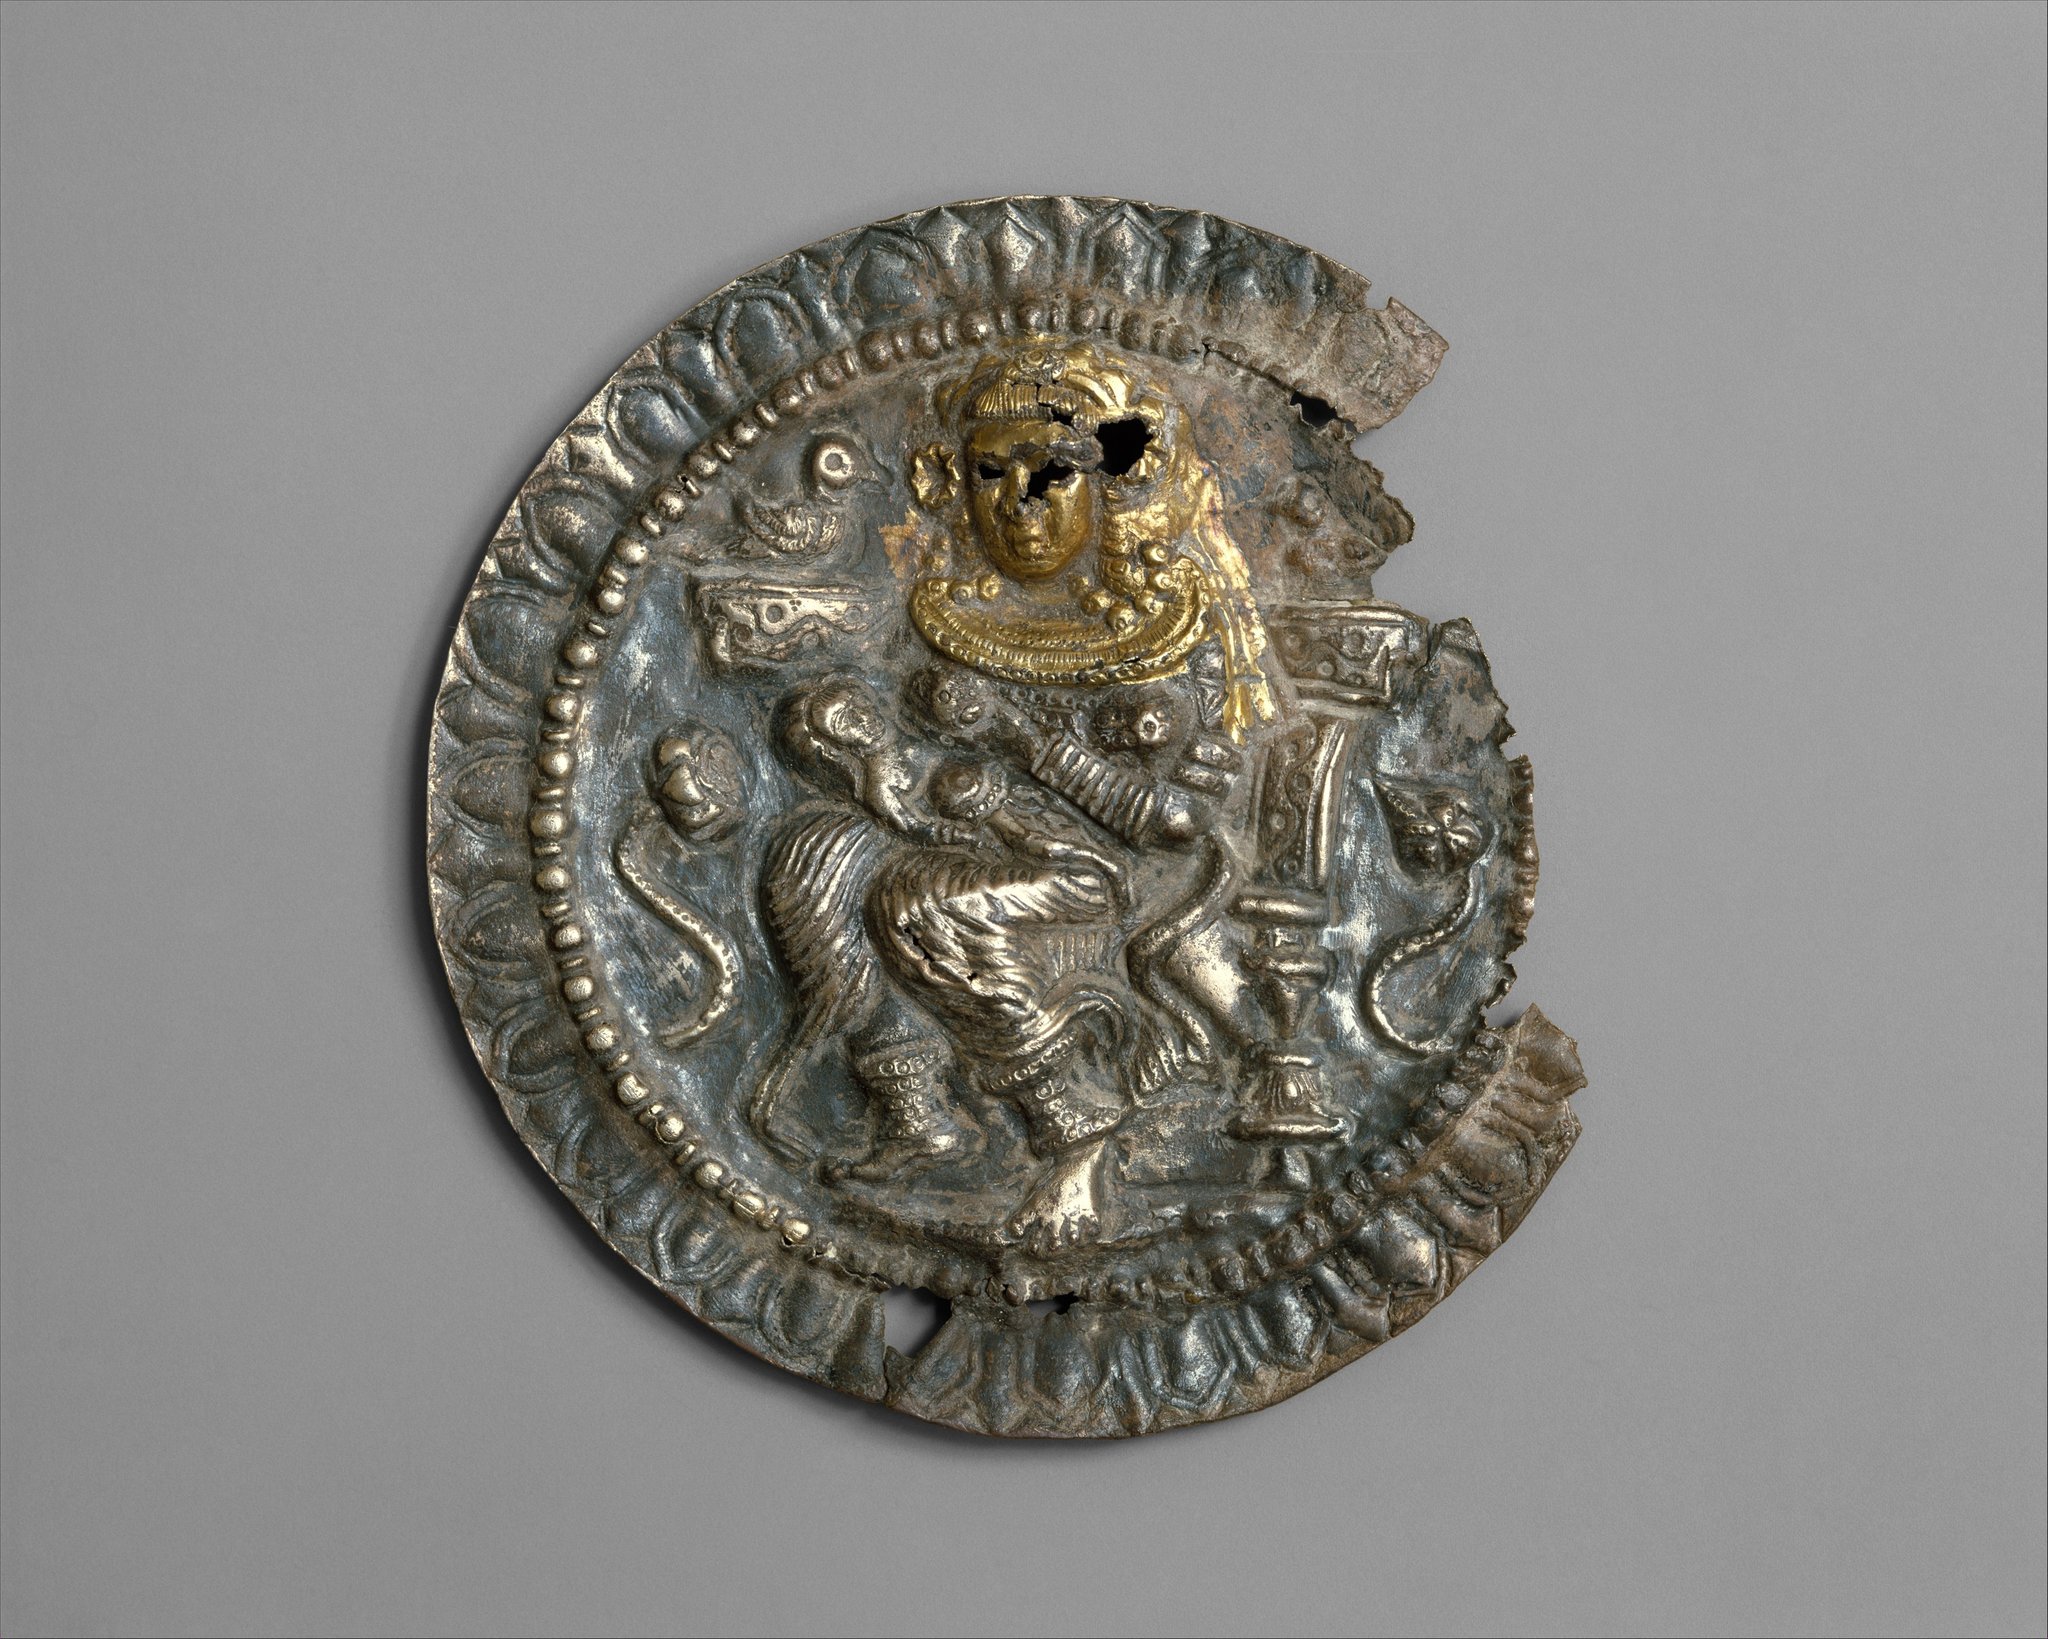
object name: rondel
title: Rondel with the Goddess Hariti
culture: gandhara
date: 1-100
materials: gold foil, silver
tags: gandhara,infants,goddess,nursing